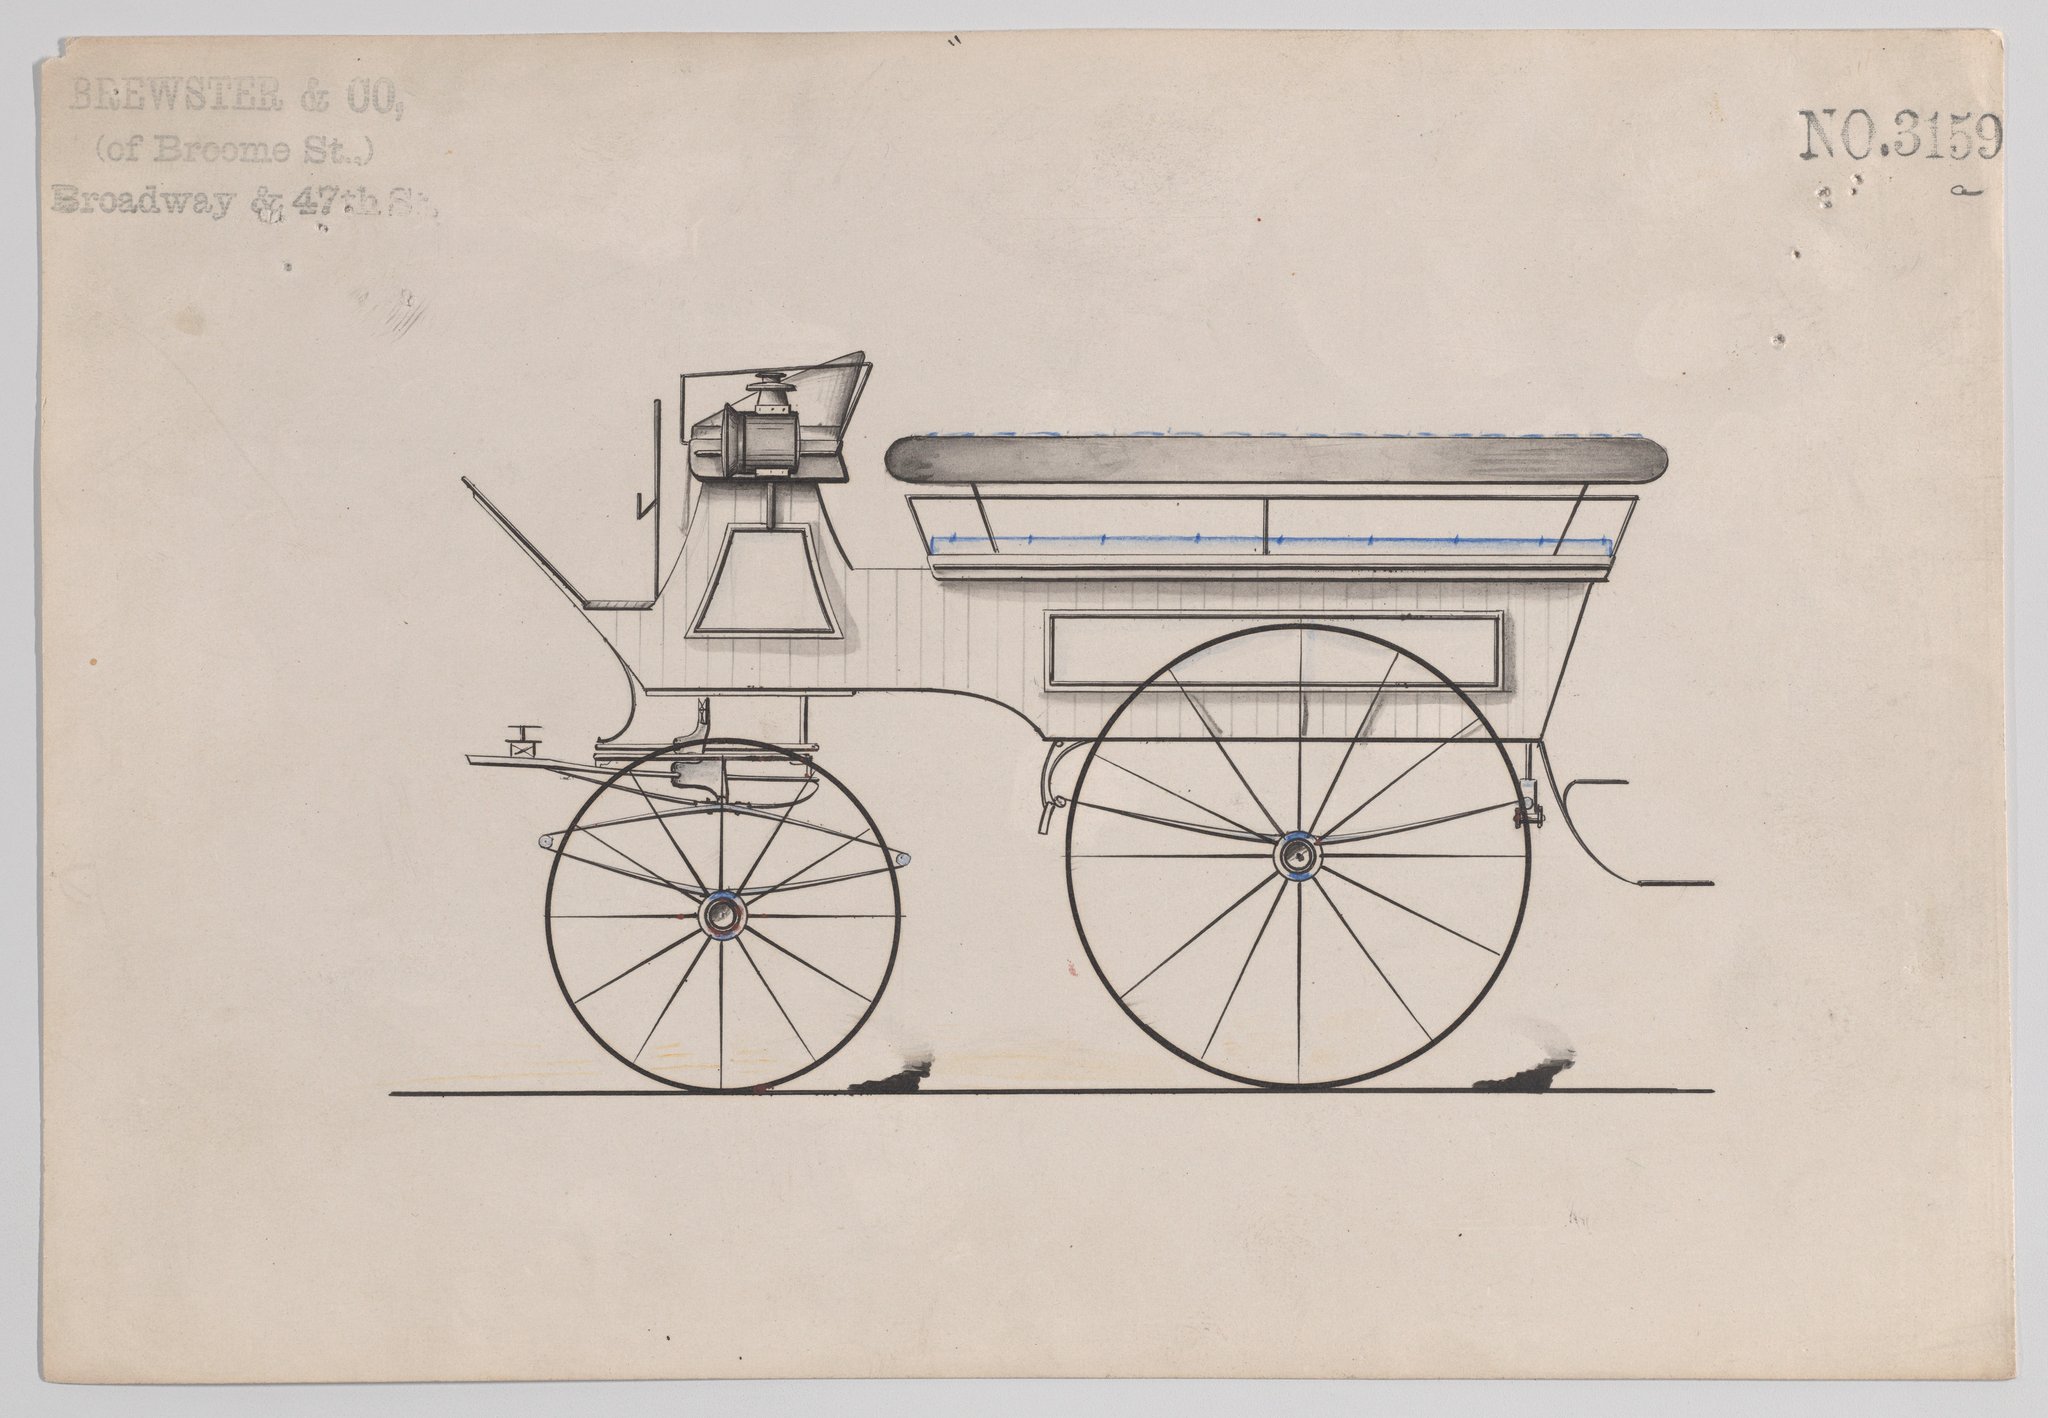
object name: drawing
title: Design for a Wagonette, no. 3159a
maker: brewster & co.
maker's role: manufacturer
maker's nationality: american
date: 1875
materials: gouache, ink, watercolor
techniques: pen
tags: carriages